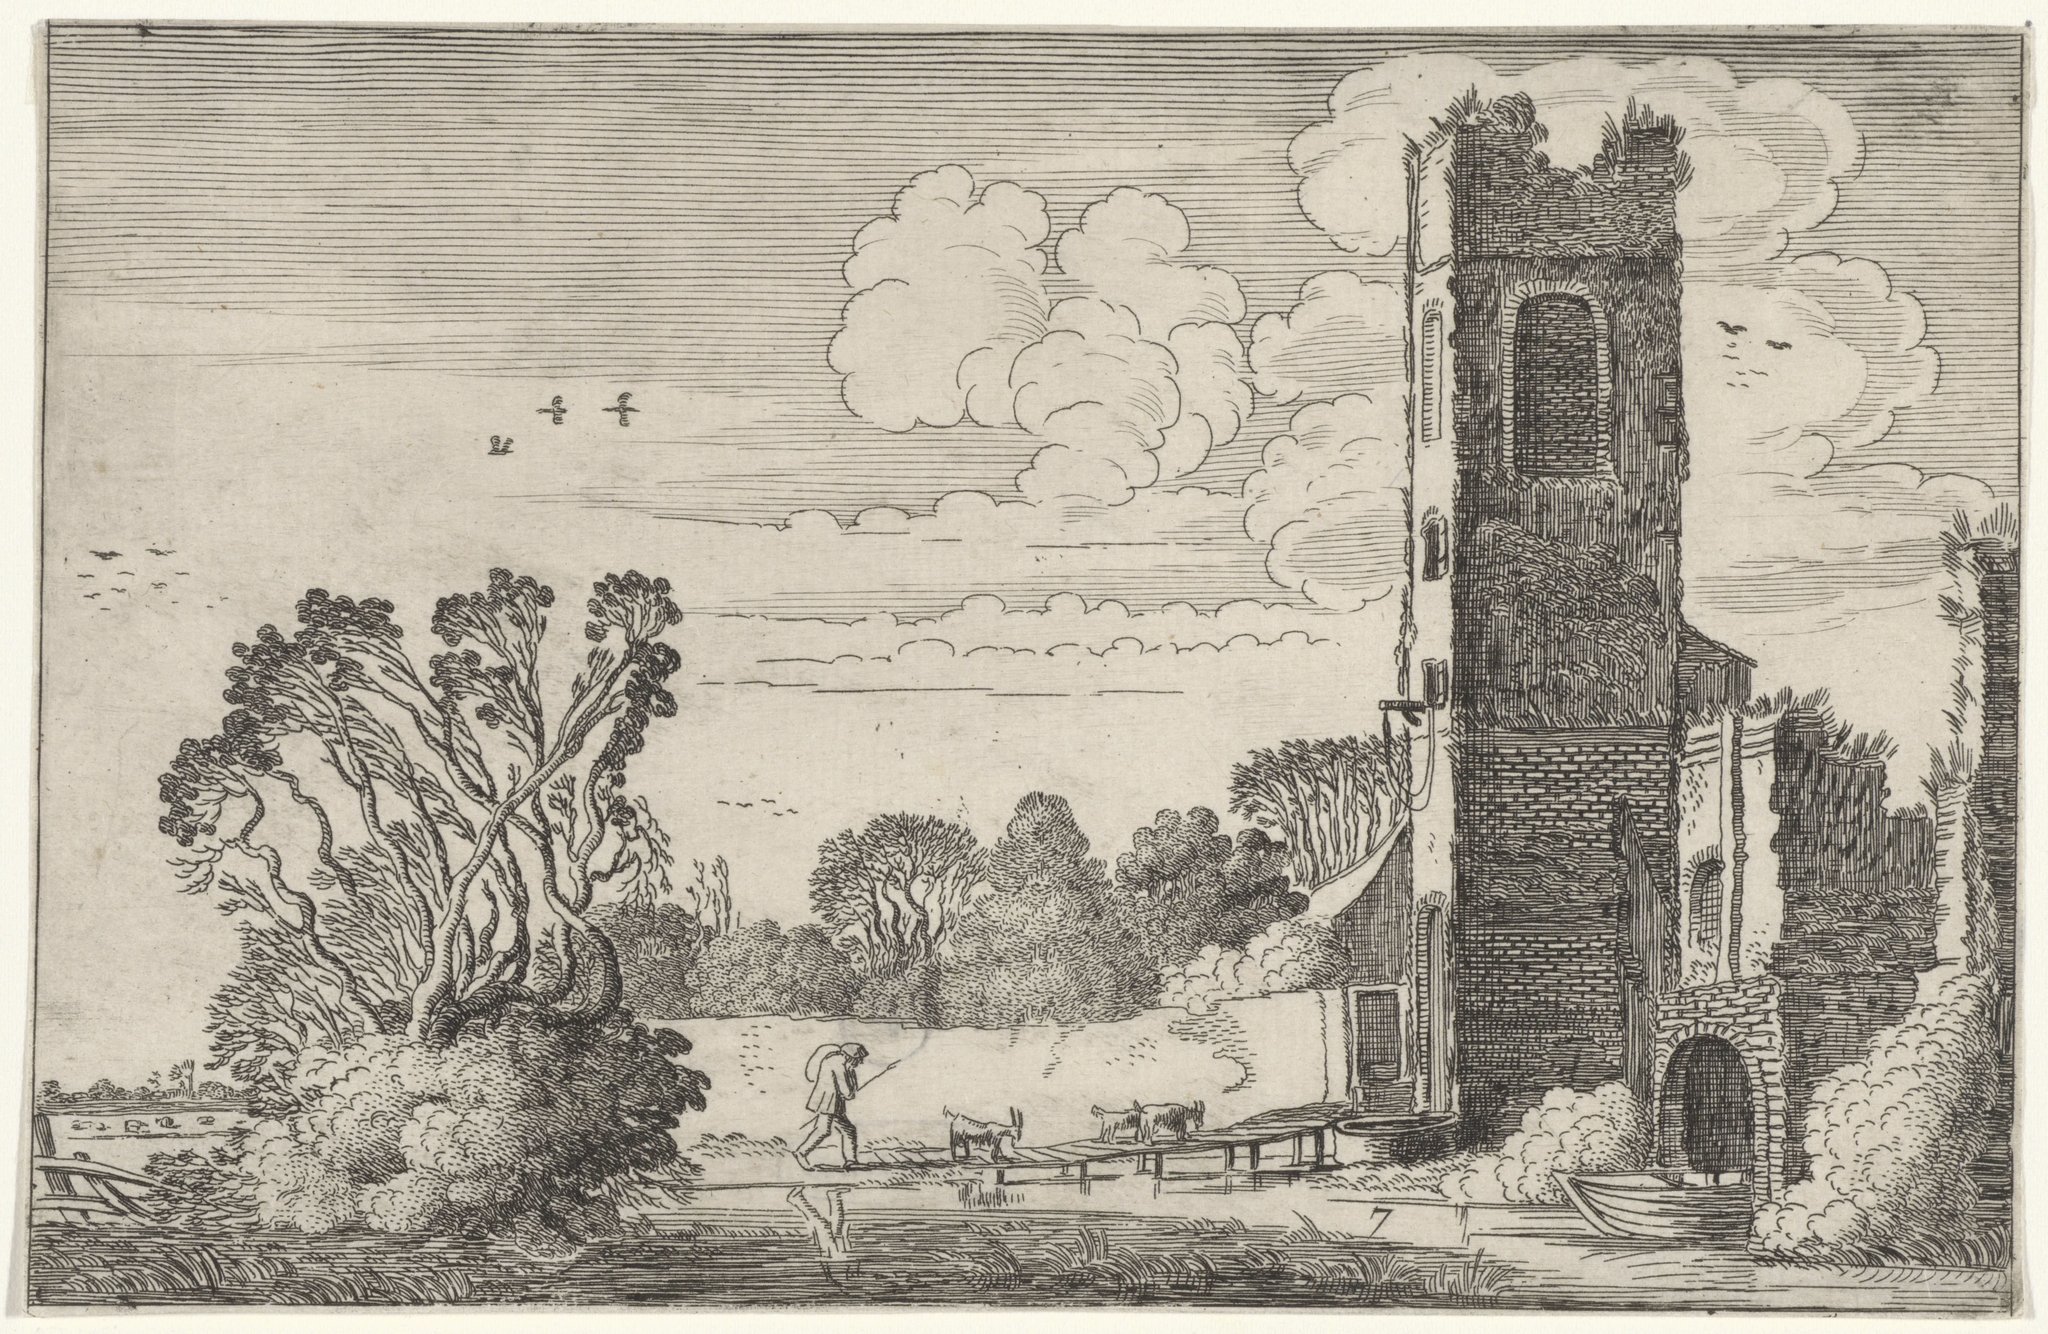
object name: print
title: Vetustae Ruinae et Venustissimae aliquot Regiones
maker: jan van de velde (ii)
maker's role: draughtsman, painter, print maker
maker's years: 1593-1641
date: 1616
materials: paper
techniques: etching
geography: northern netherlands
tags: herding, herdsman, herdswoman, shepherd, shepherdess, cowherd, etc., landscape with ruins, landscape with tower or castle, ruin of a dwelling, house, castle, etc.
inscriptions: collector's mark: Lugt 964, collector's mark: Lugt 698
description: Een herder met drie geiten op een houten brug bij een ruïne van een toren in een landschap. Zevende prent van een serie van zestien.